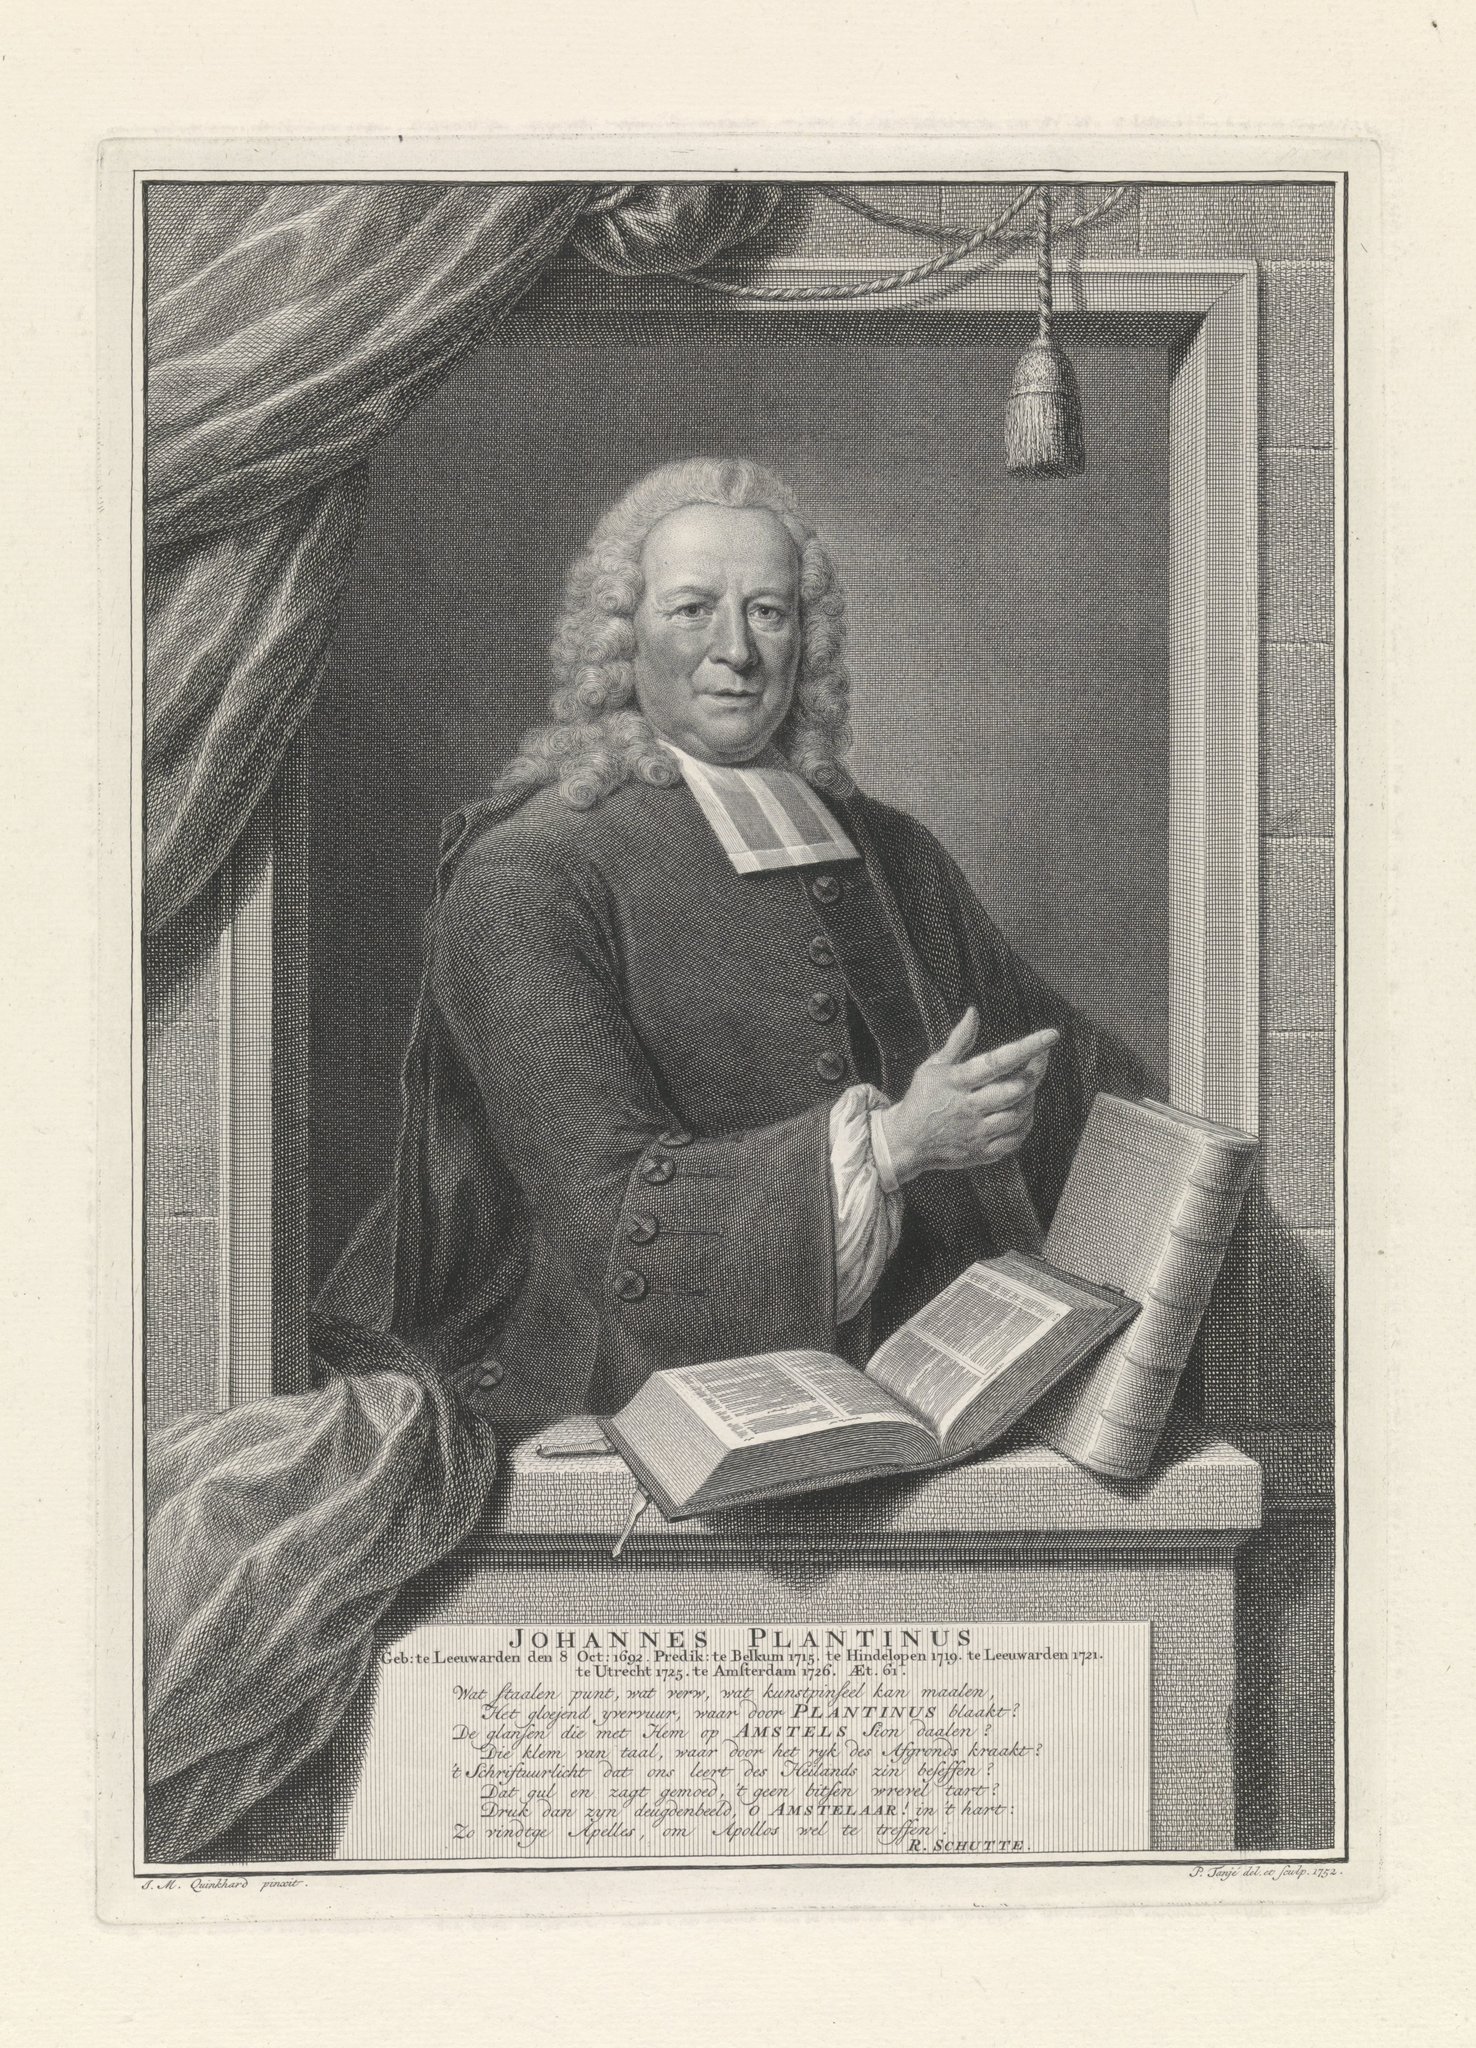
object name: print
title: Portret van Johannes Plantinus op 61-jarige leeftijd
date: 1752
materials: paper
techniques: engraving, etching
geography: amsterdam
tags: historical persons, the bible as a book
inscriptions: collector's mark: Lugt 240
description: Johannes Plantinus, predikant te Amsterdam, op 61-jarige leeftijd. Hij staat bij een opengeslagen Bijbel. Onderaan een achtregelig vers in het Nederlands.